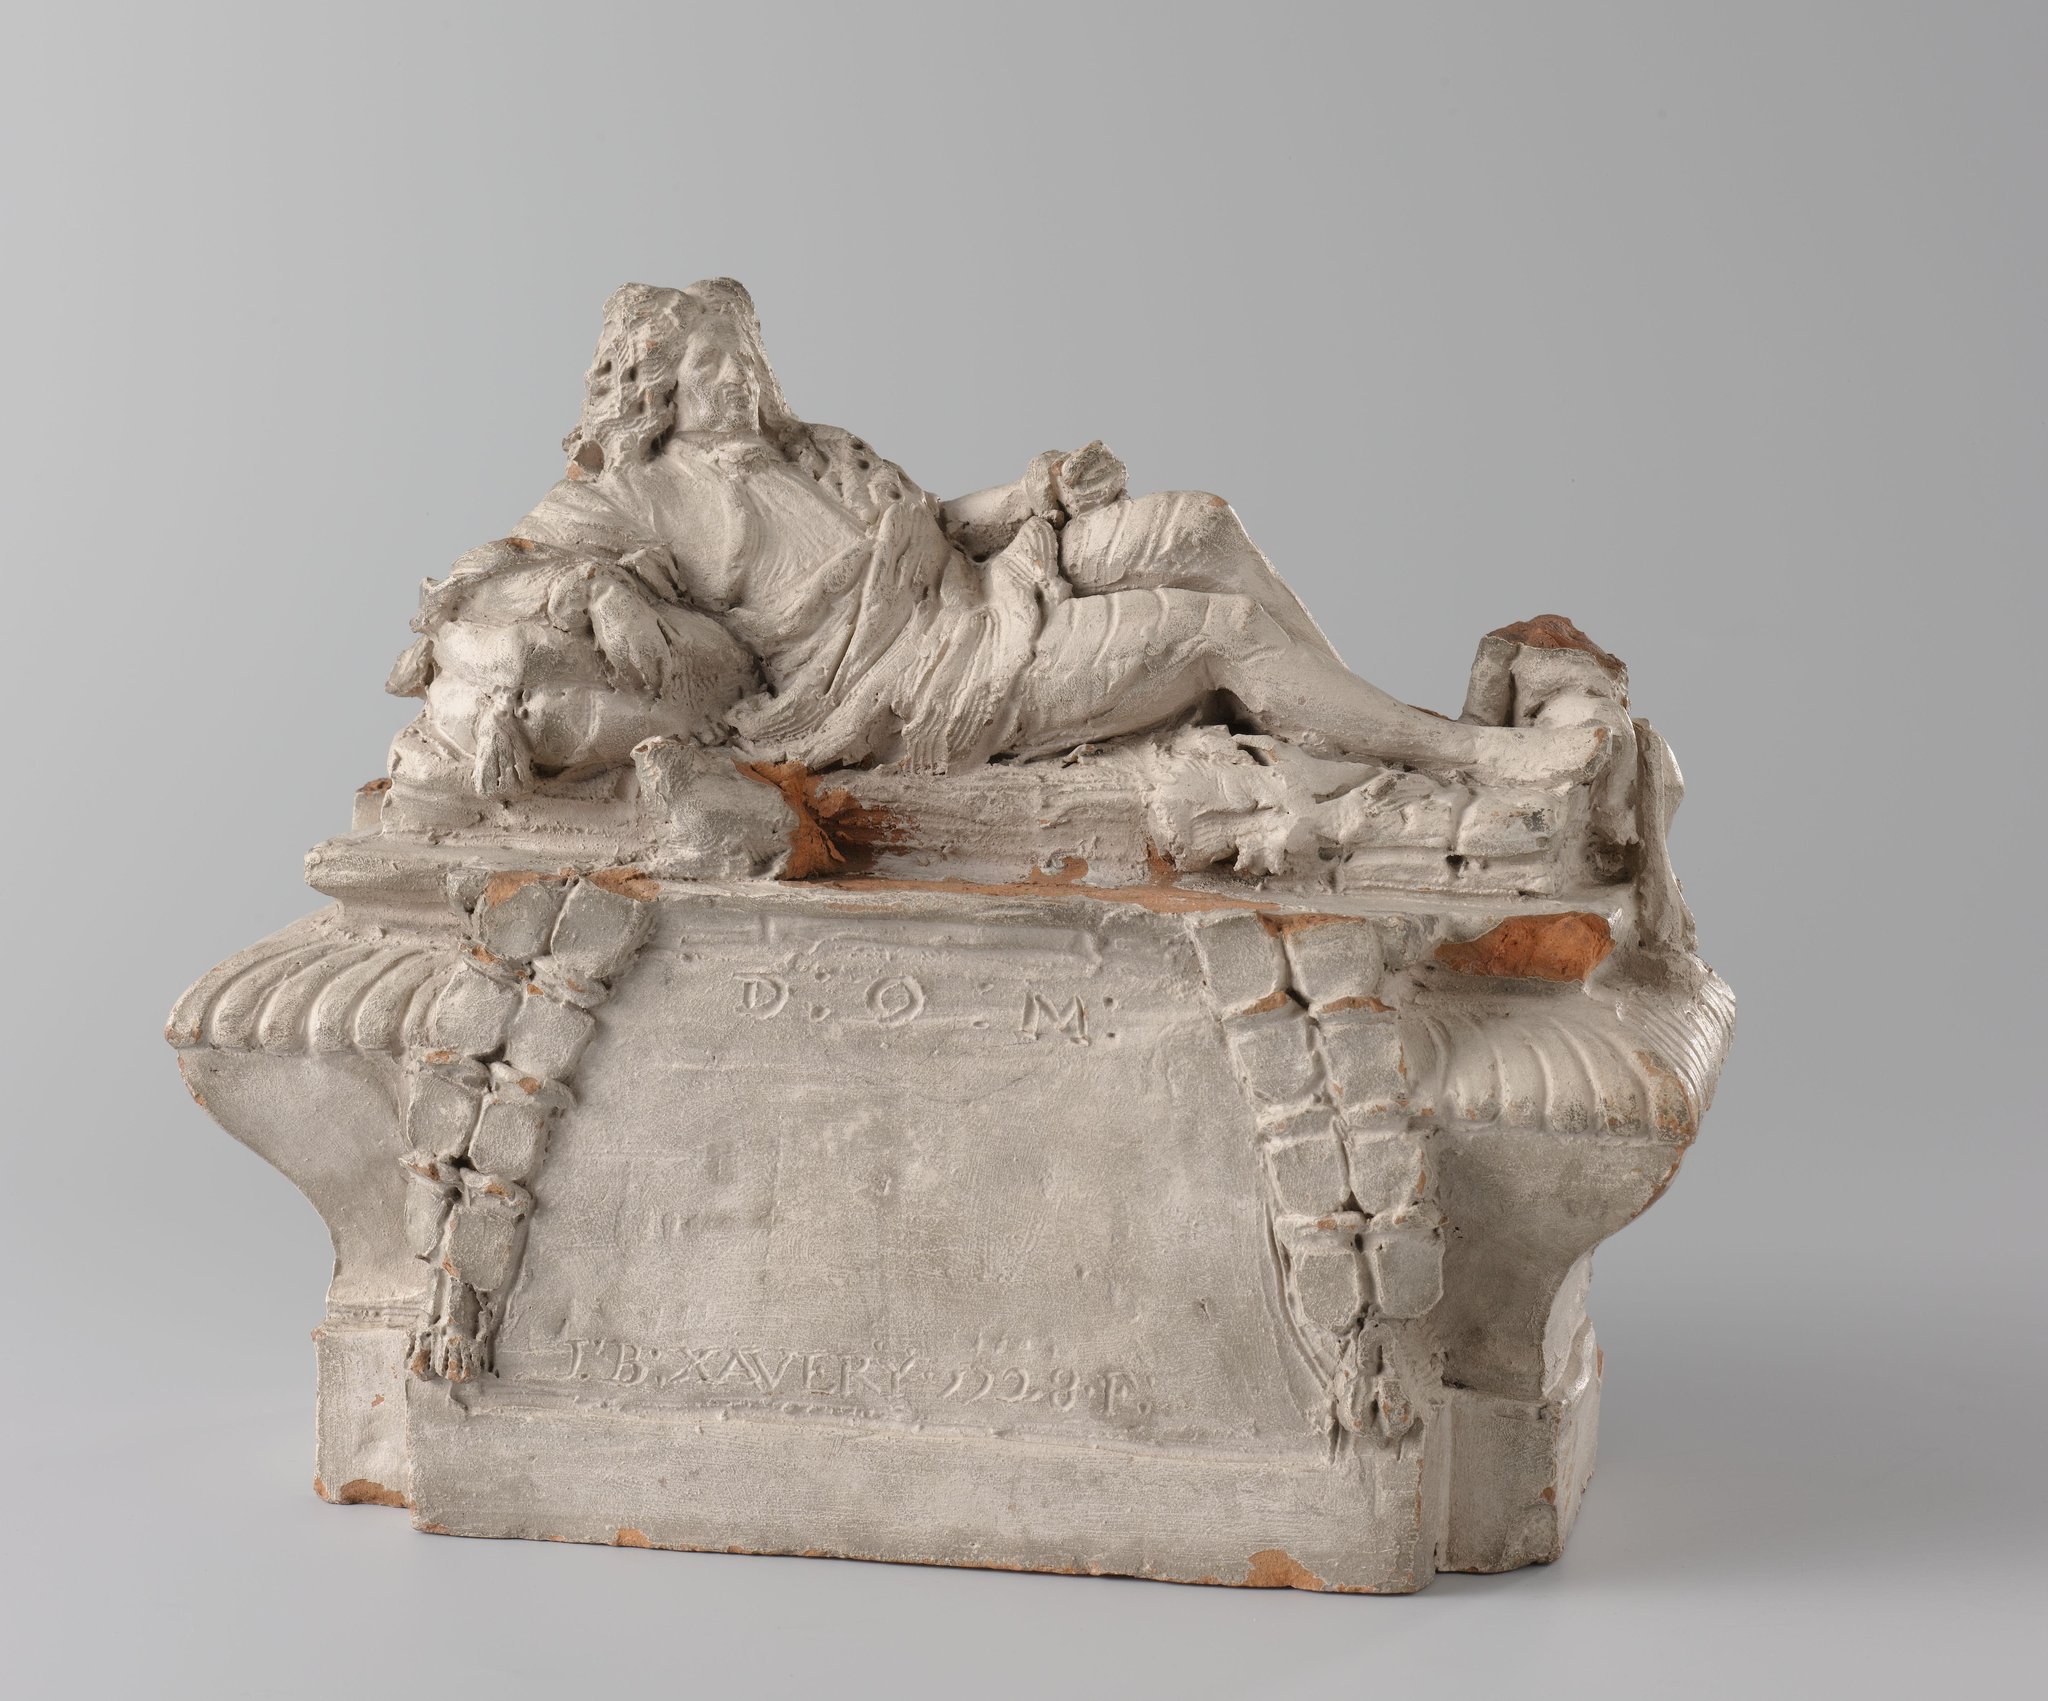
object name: sculpture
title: Bozzetto for a Funerary Monument, Probably for Lieutenant-General Count Reinhard Vincent von Hompesch (c. 1660-1733)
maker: jan baptist xavery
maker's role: sculptor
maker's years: 1697-1742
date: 1728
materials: terracotta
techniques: modeling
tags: johan theodoor baron van friesheim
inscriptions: signature and date, on the sarcophagus, incised in the wet clay: ‘D: O: M: / : J: B: XAVERŸ. 1728. F:’